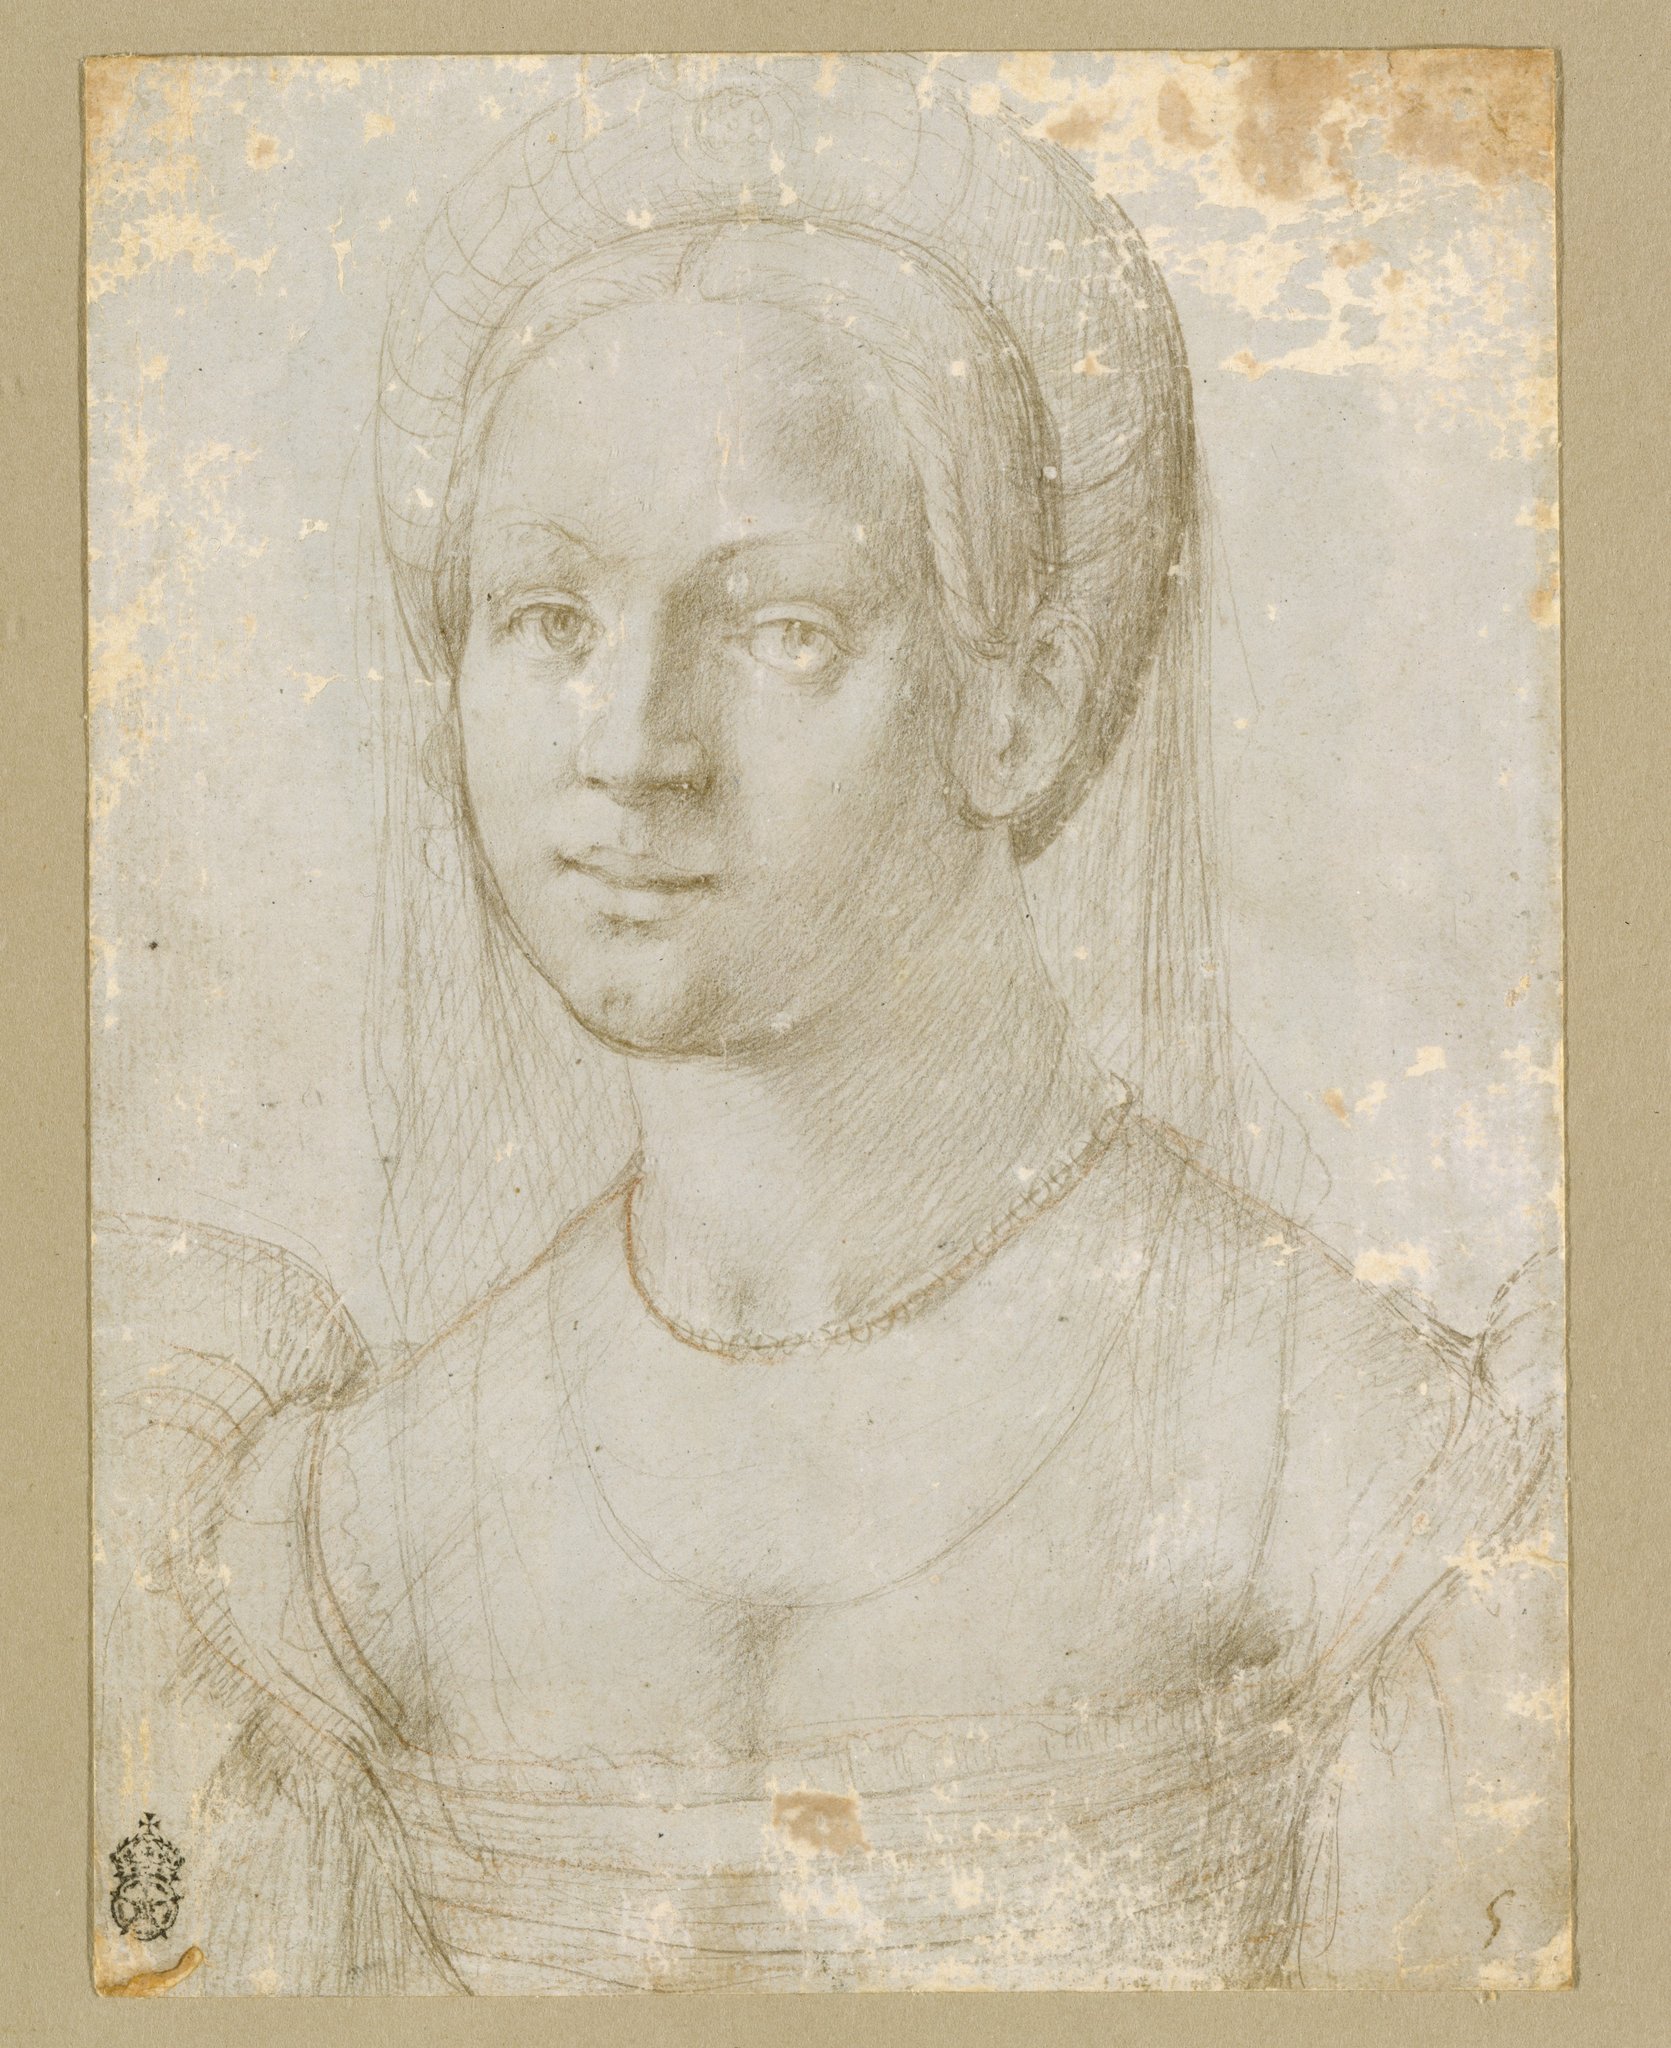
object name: drawing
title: Portrait of a Young Woman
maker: pier francesco foschi (pier francesco toschi)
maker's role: artist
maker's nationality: florence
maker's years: 1502-1567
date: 1520-1539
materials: chalk, paper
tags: portraits,women